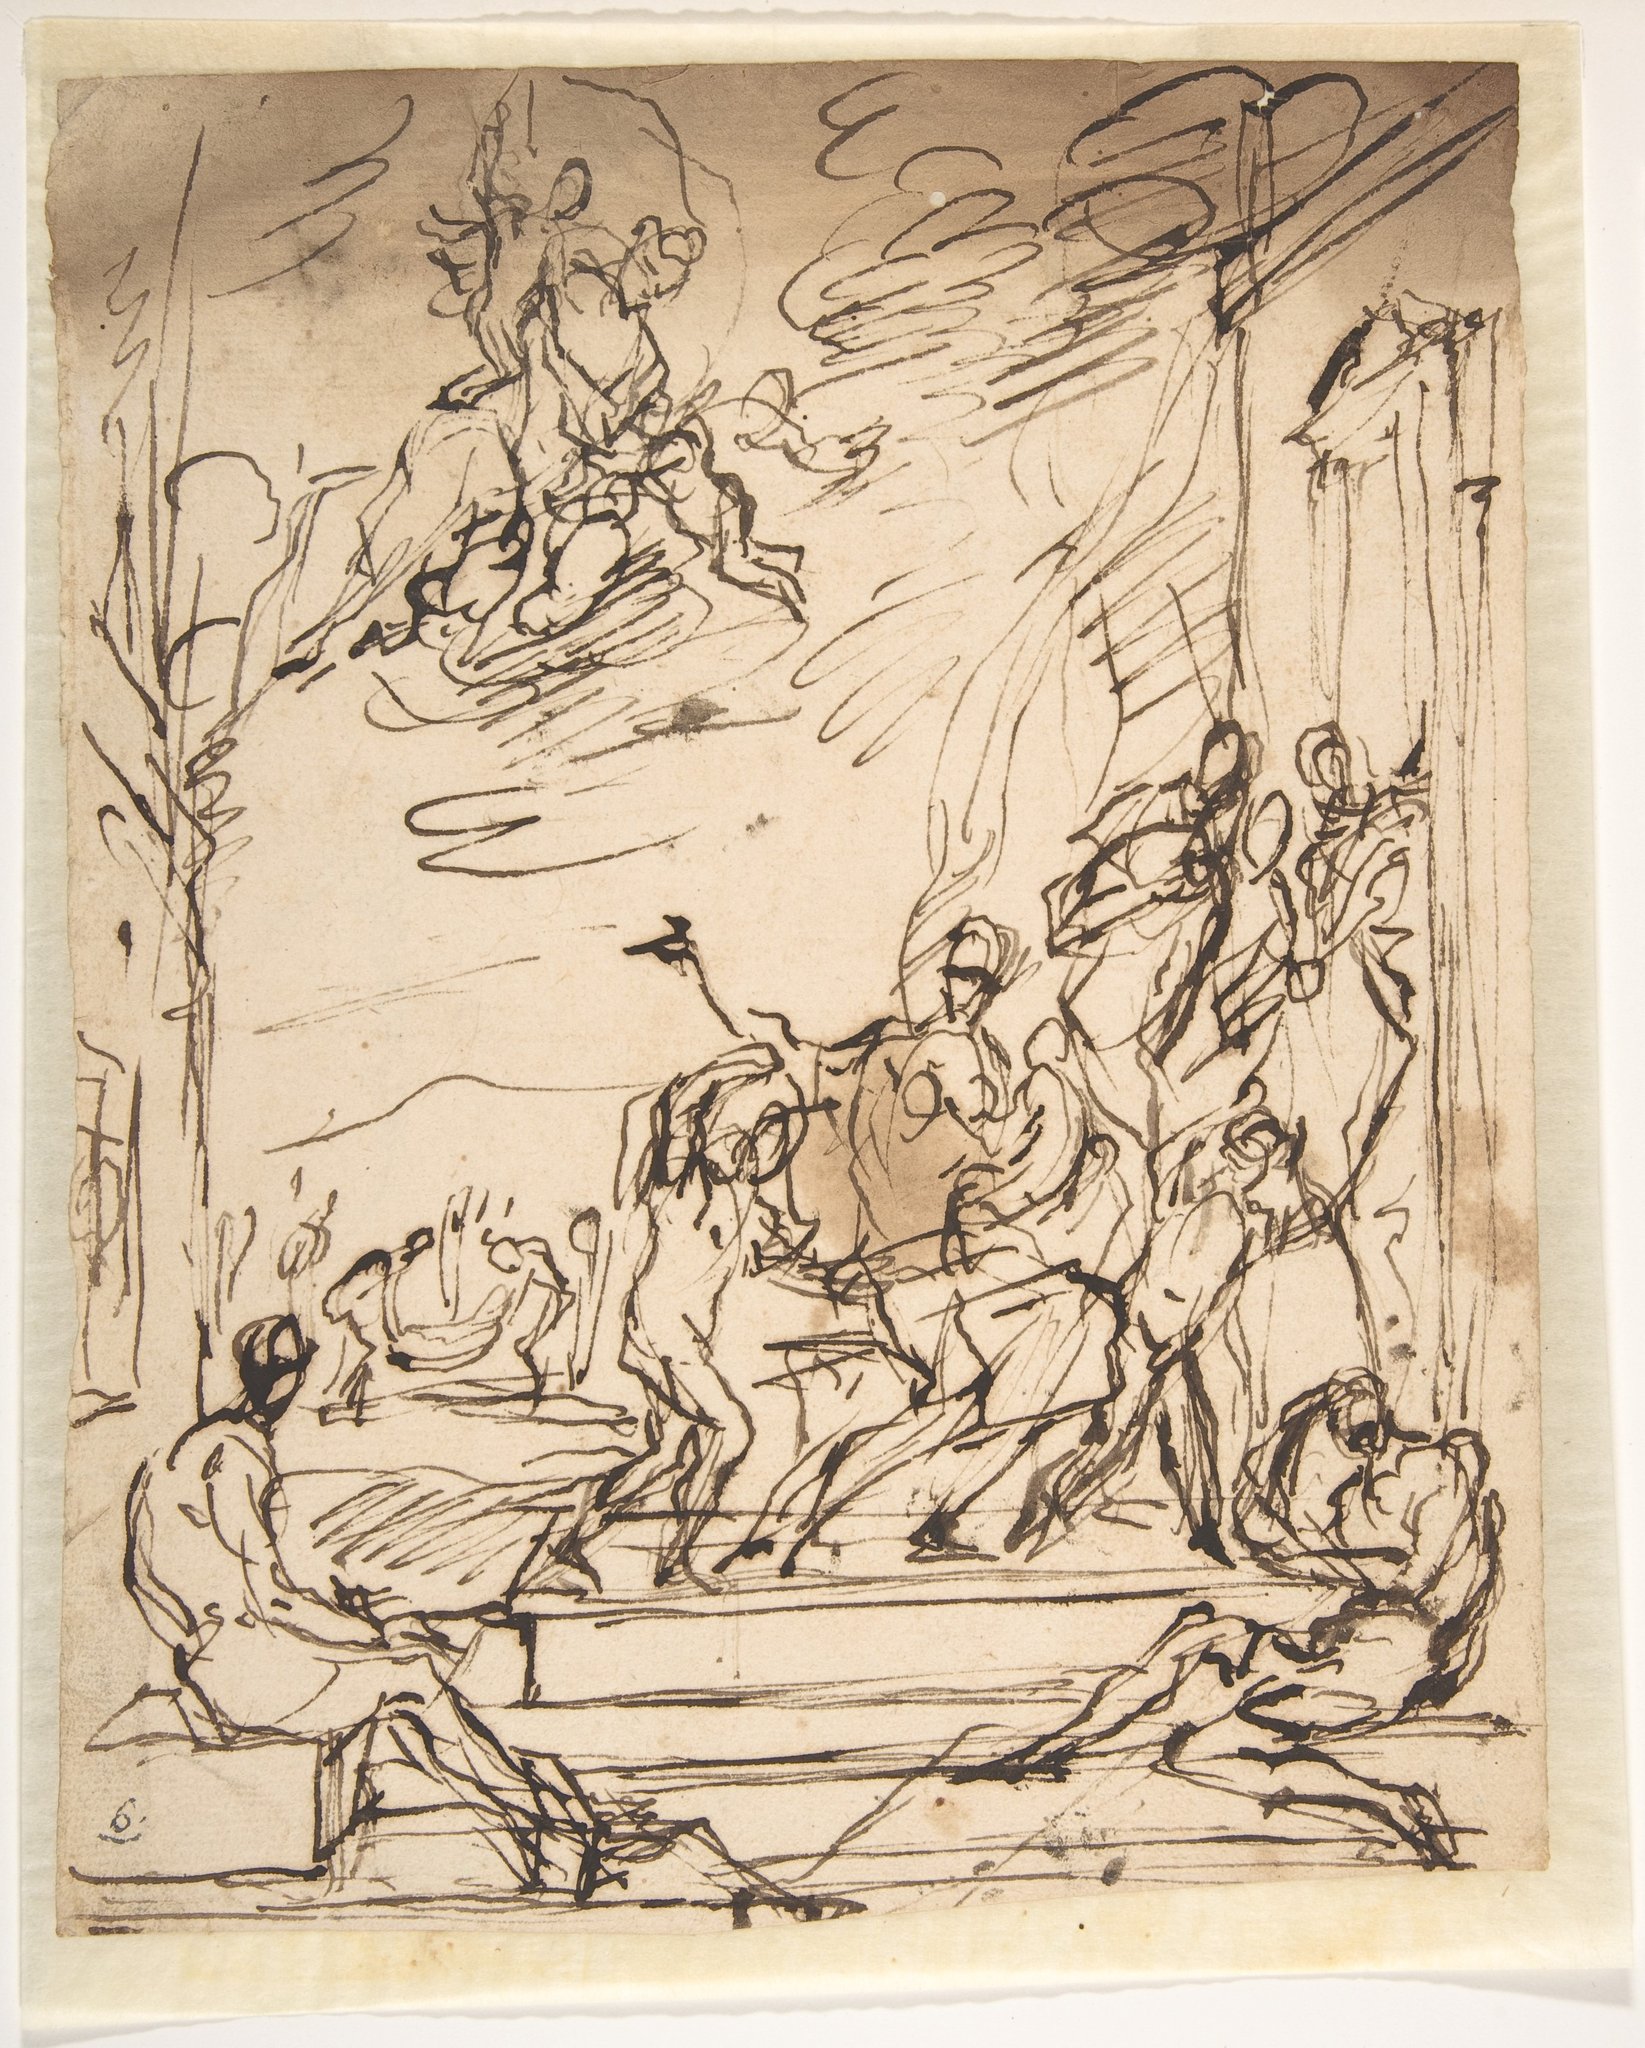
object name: drawing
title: Unidentified Subject: Scene of Martyrdom ?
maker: micco spadaro (domenico gargiulo)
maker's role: artist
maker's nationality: italian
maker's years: 1609-1675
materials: ink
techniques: pen